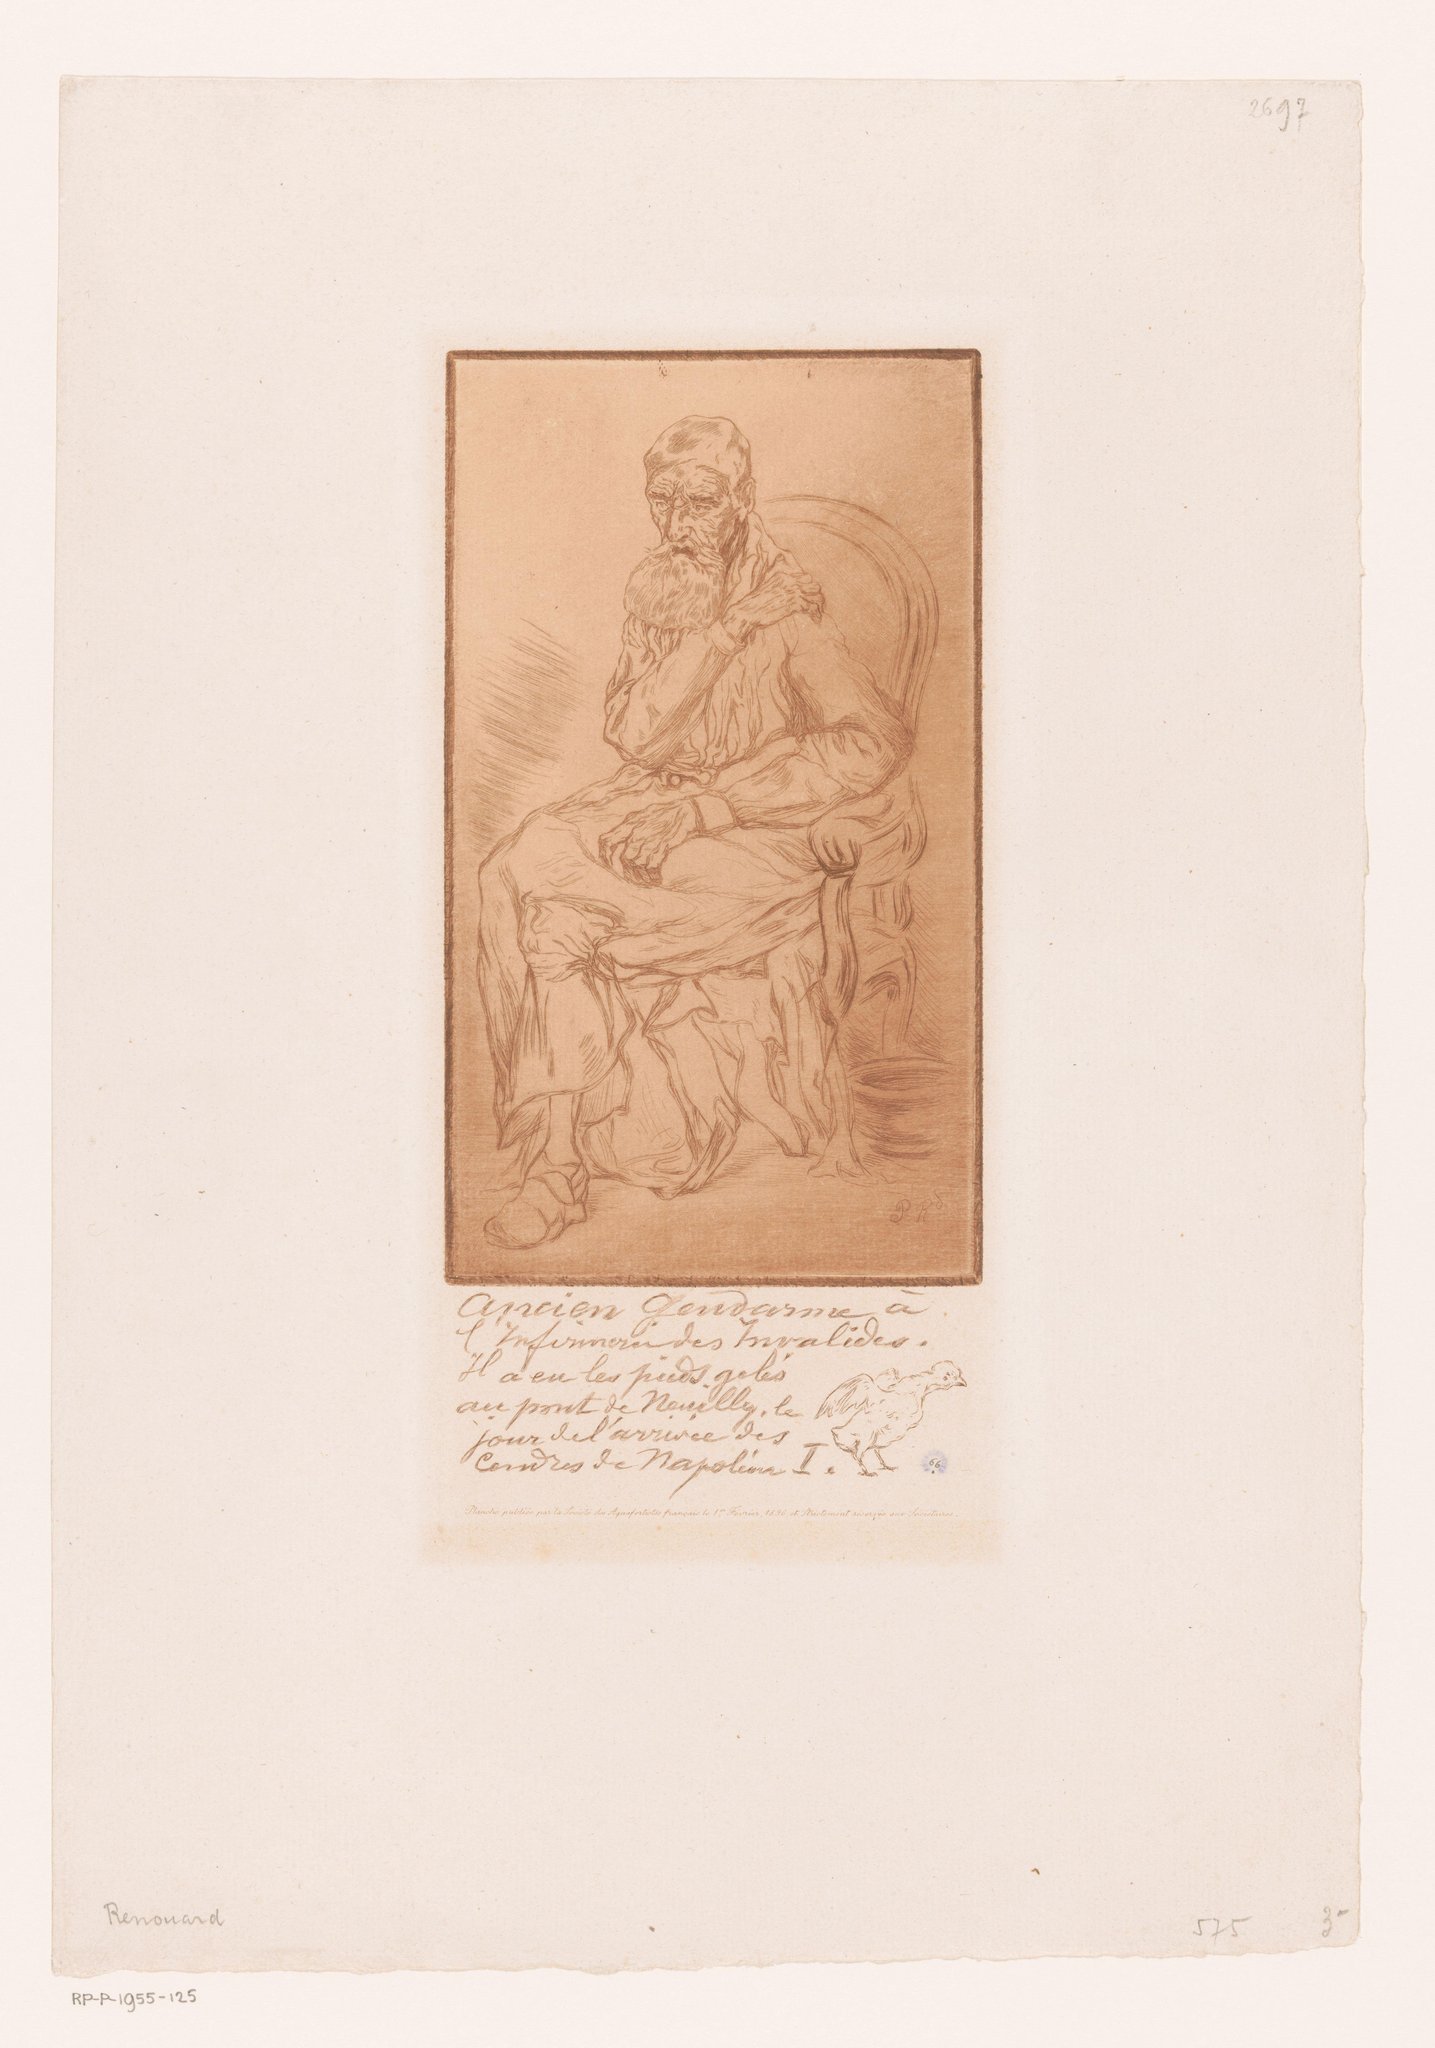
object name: print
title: Portret van een onbekende man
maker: paul renouard (1845-1924)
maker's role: painter, print maker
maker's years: 1845-1924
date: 1855-1924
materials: paper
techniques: etching, intaglio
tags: old man, historical persons not known by name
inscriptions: collector's mark: Lugt 2228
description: Oude man, vroeger werkzaam bij de gendarmerie. Rechtsonder in de marge een kip en genummerd: 66.